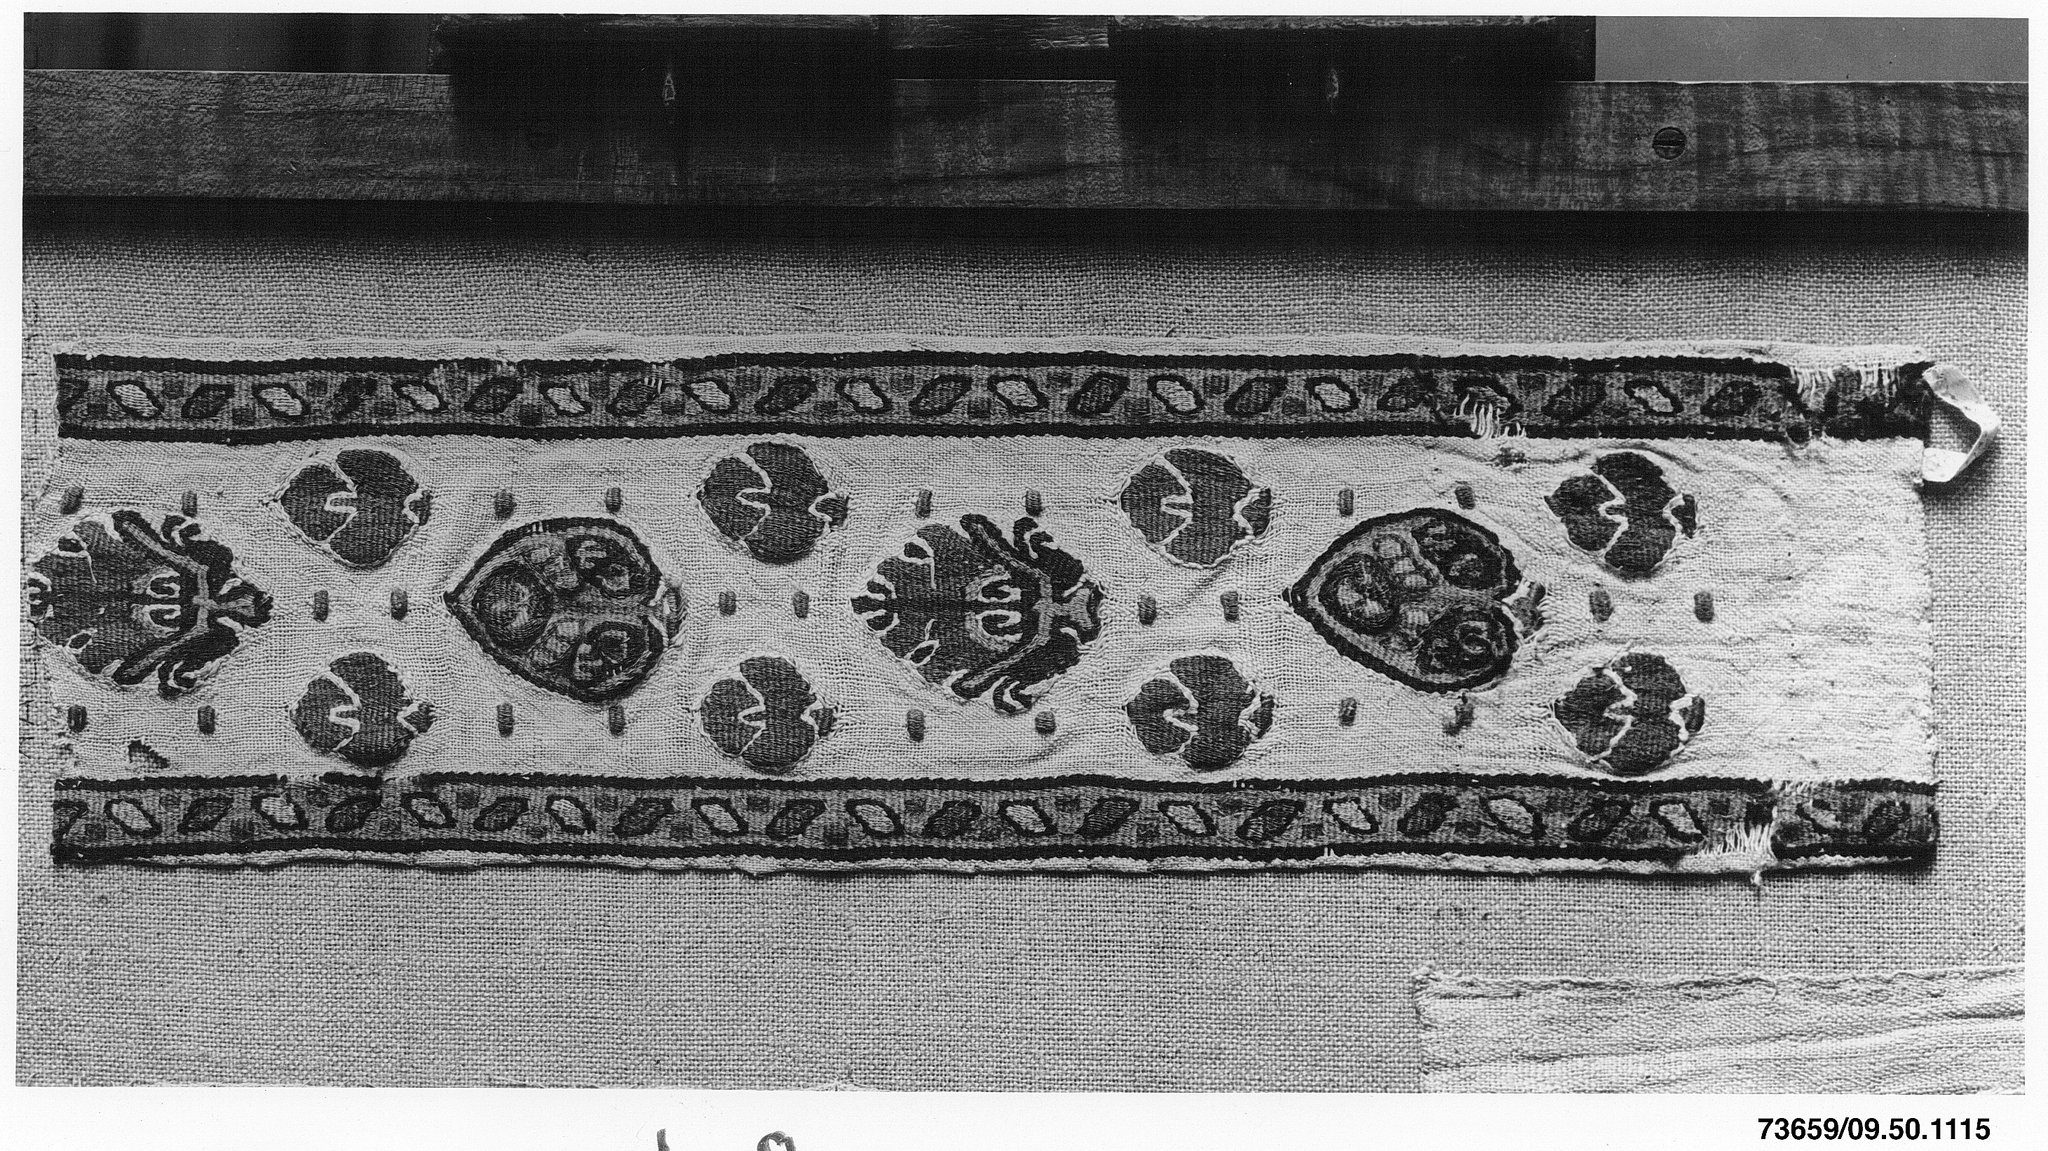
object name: band fragment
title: Fragment of an Ornamented Band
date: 601-1000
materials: linen, wool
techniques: weave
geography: egypt